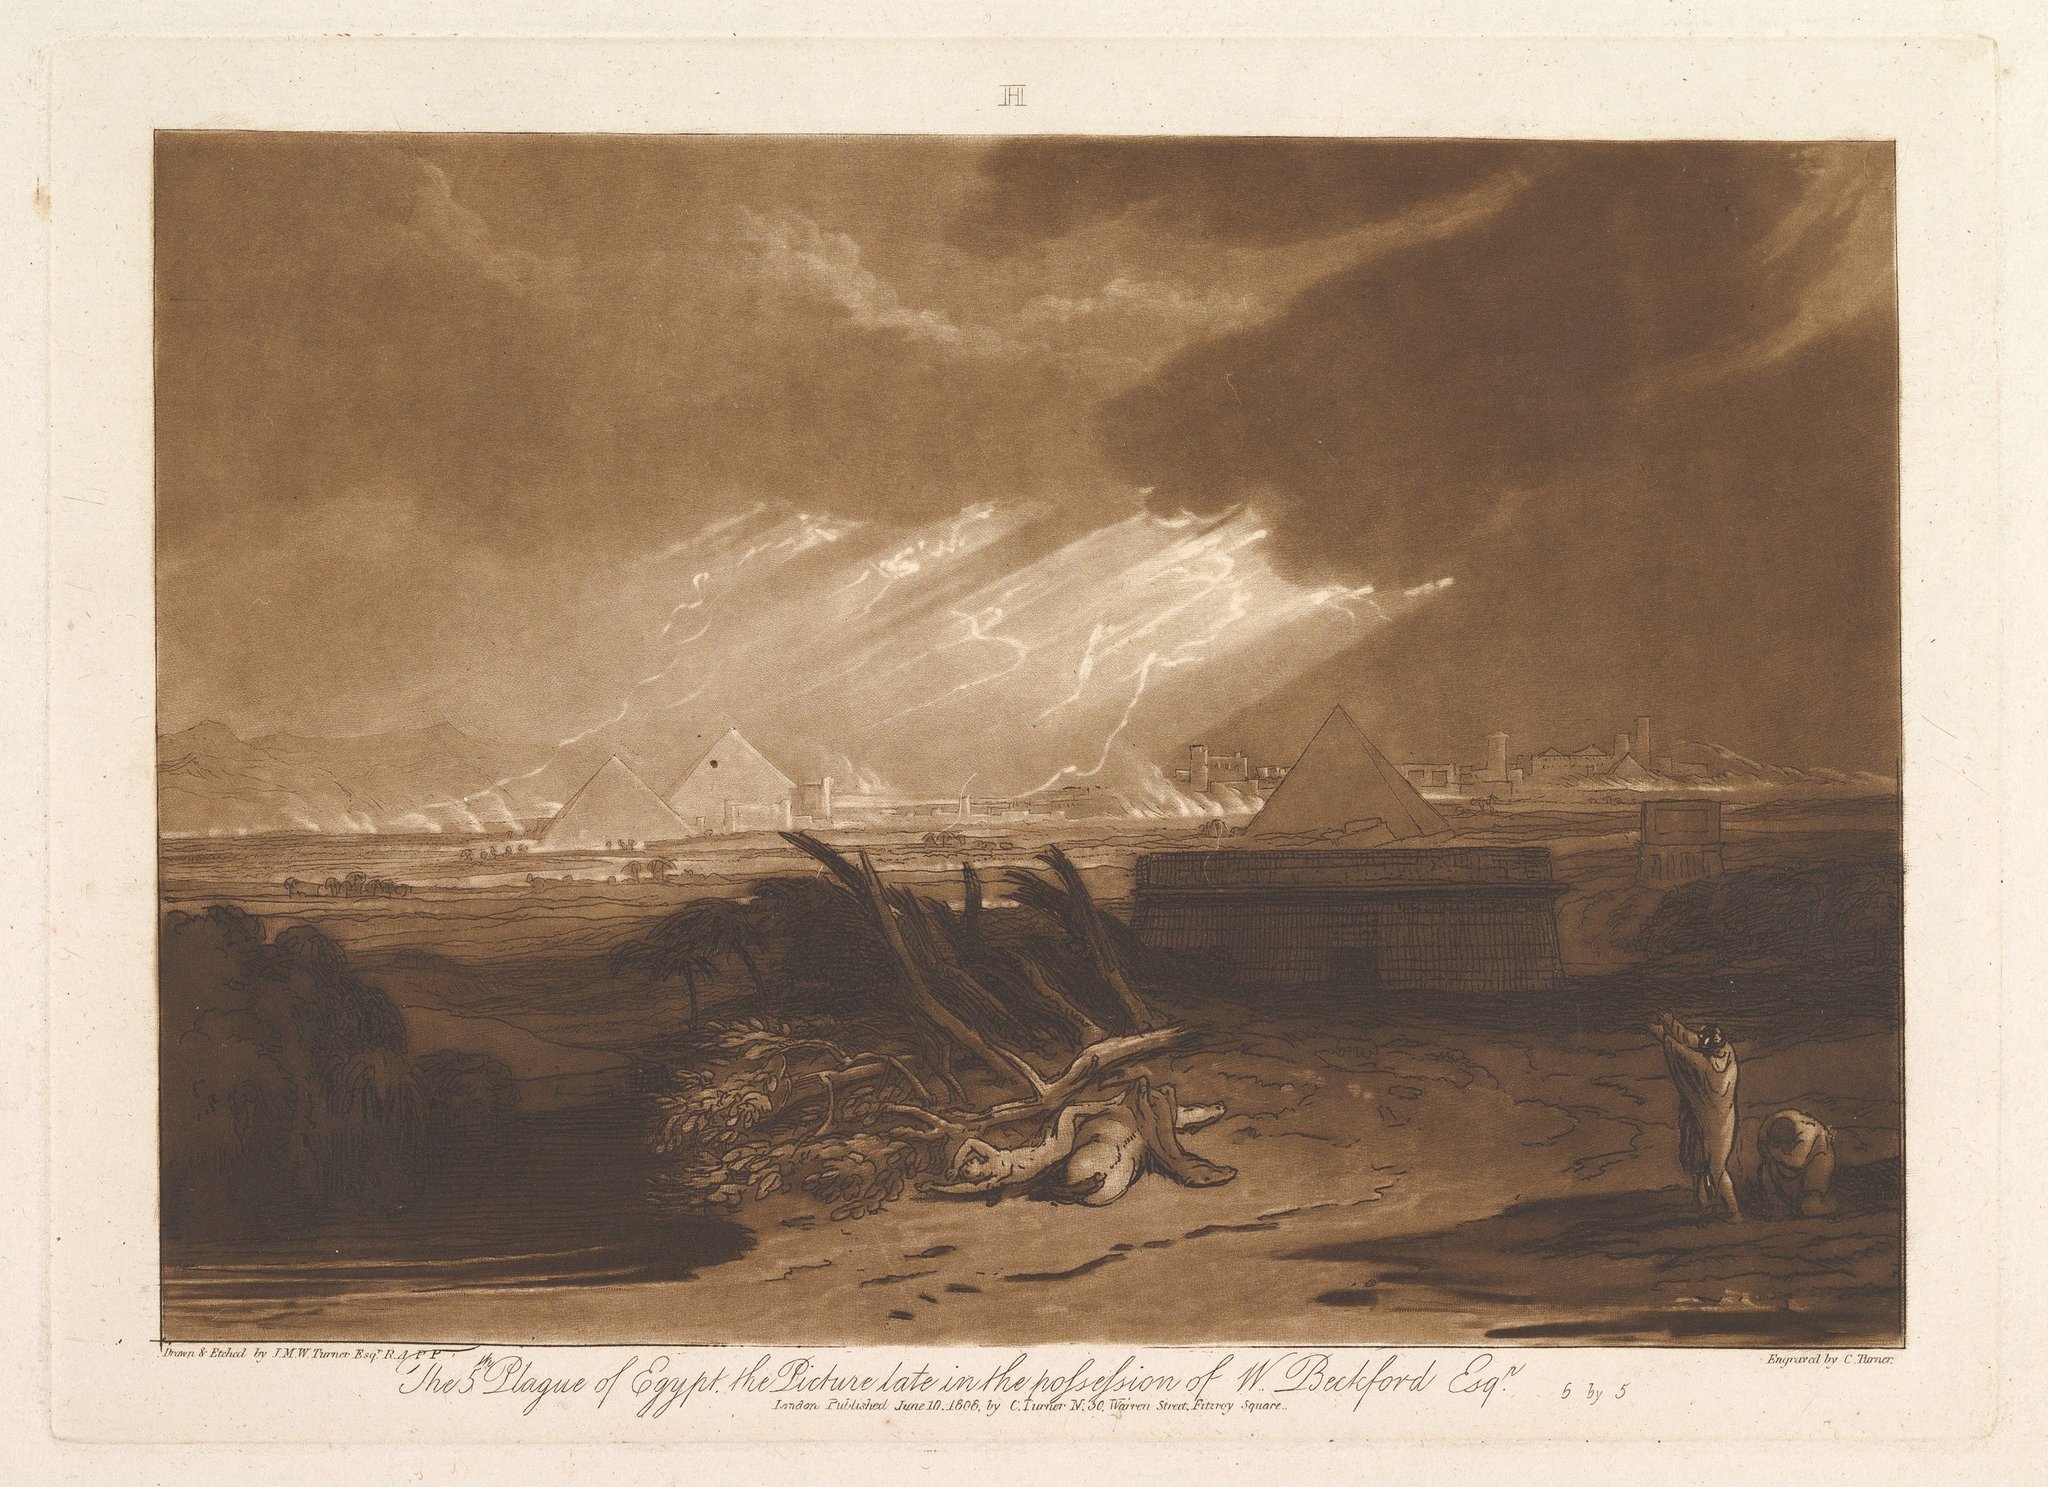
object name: print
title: The Fifth Plague of Egypt (Liber Studiorum, part III, plate 16)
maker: joseph mallord william turner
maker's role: artist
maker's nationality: british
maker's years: 1775-1851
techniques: etching, mezzotint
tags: pyramids,sky,lightning